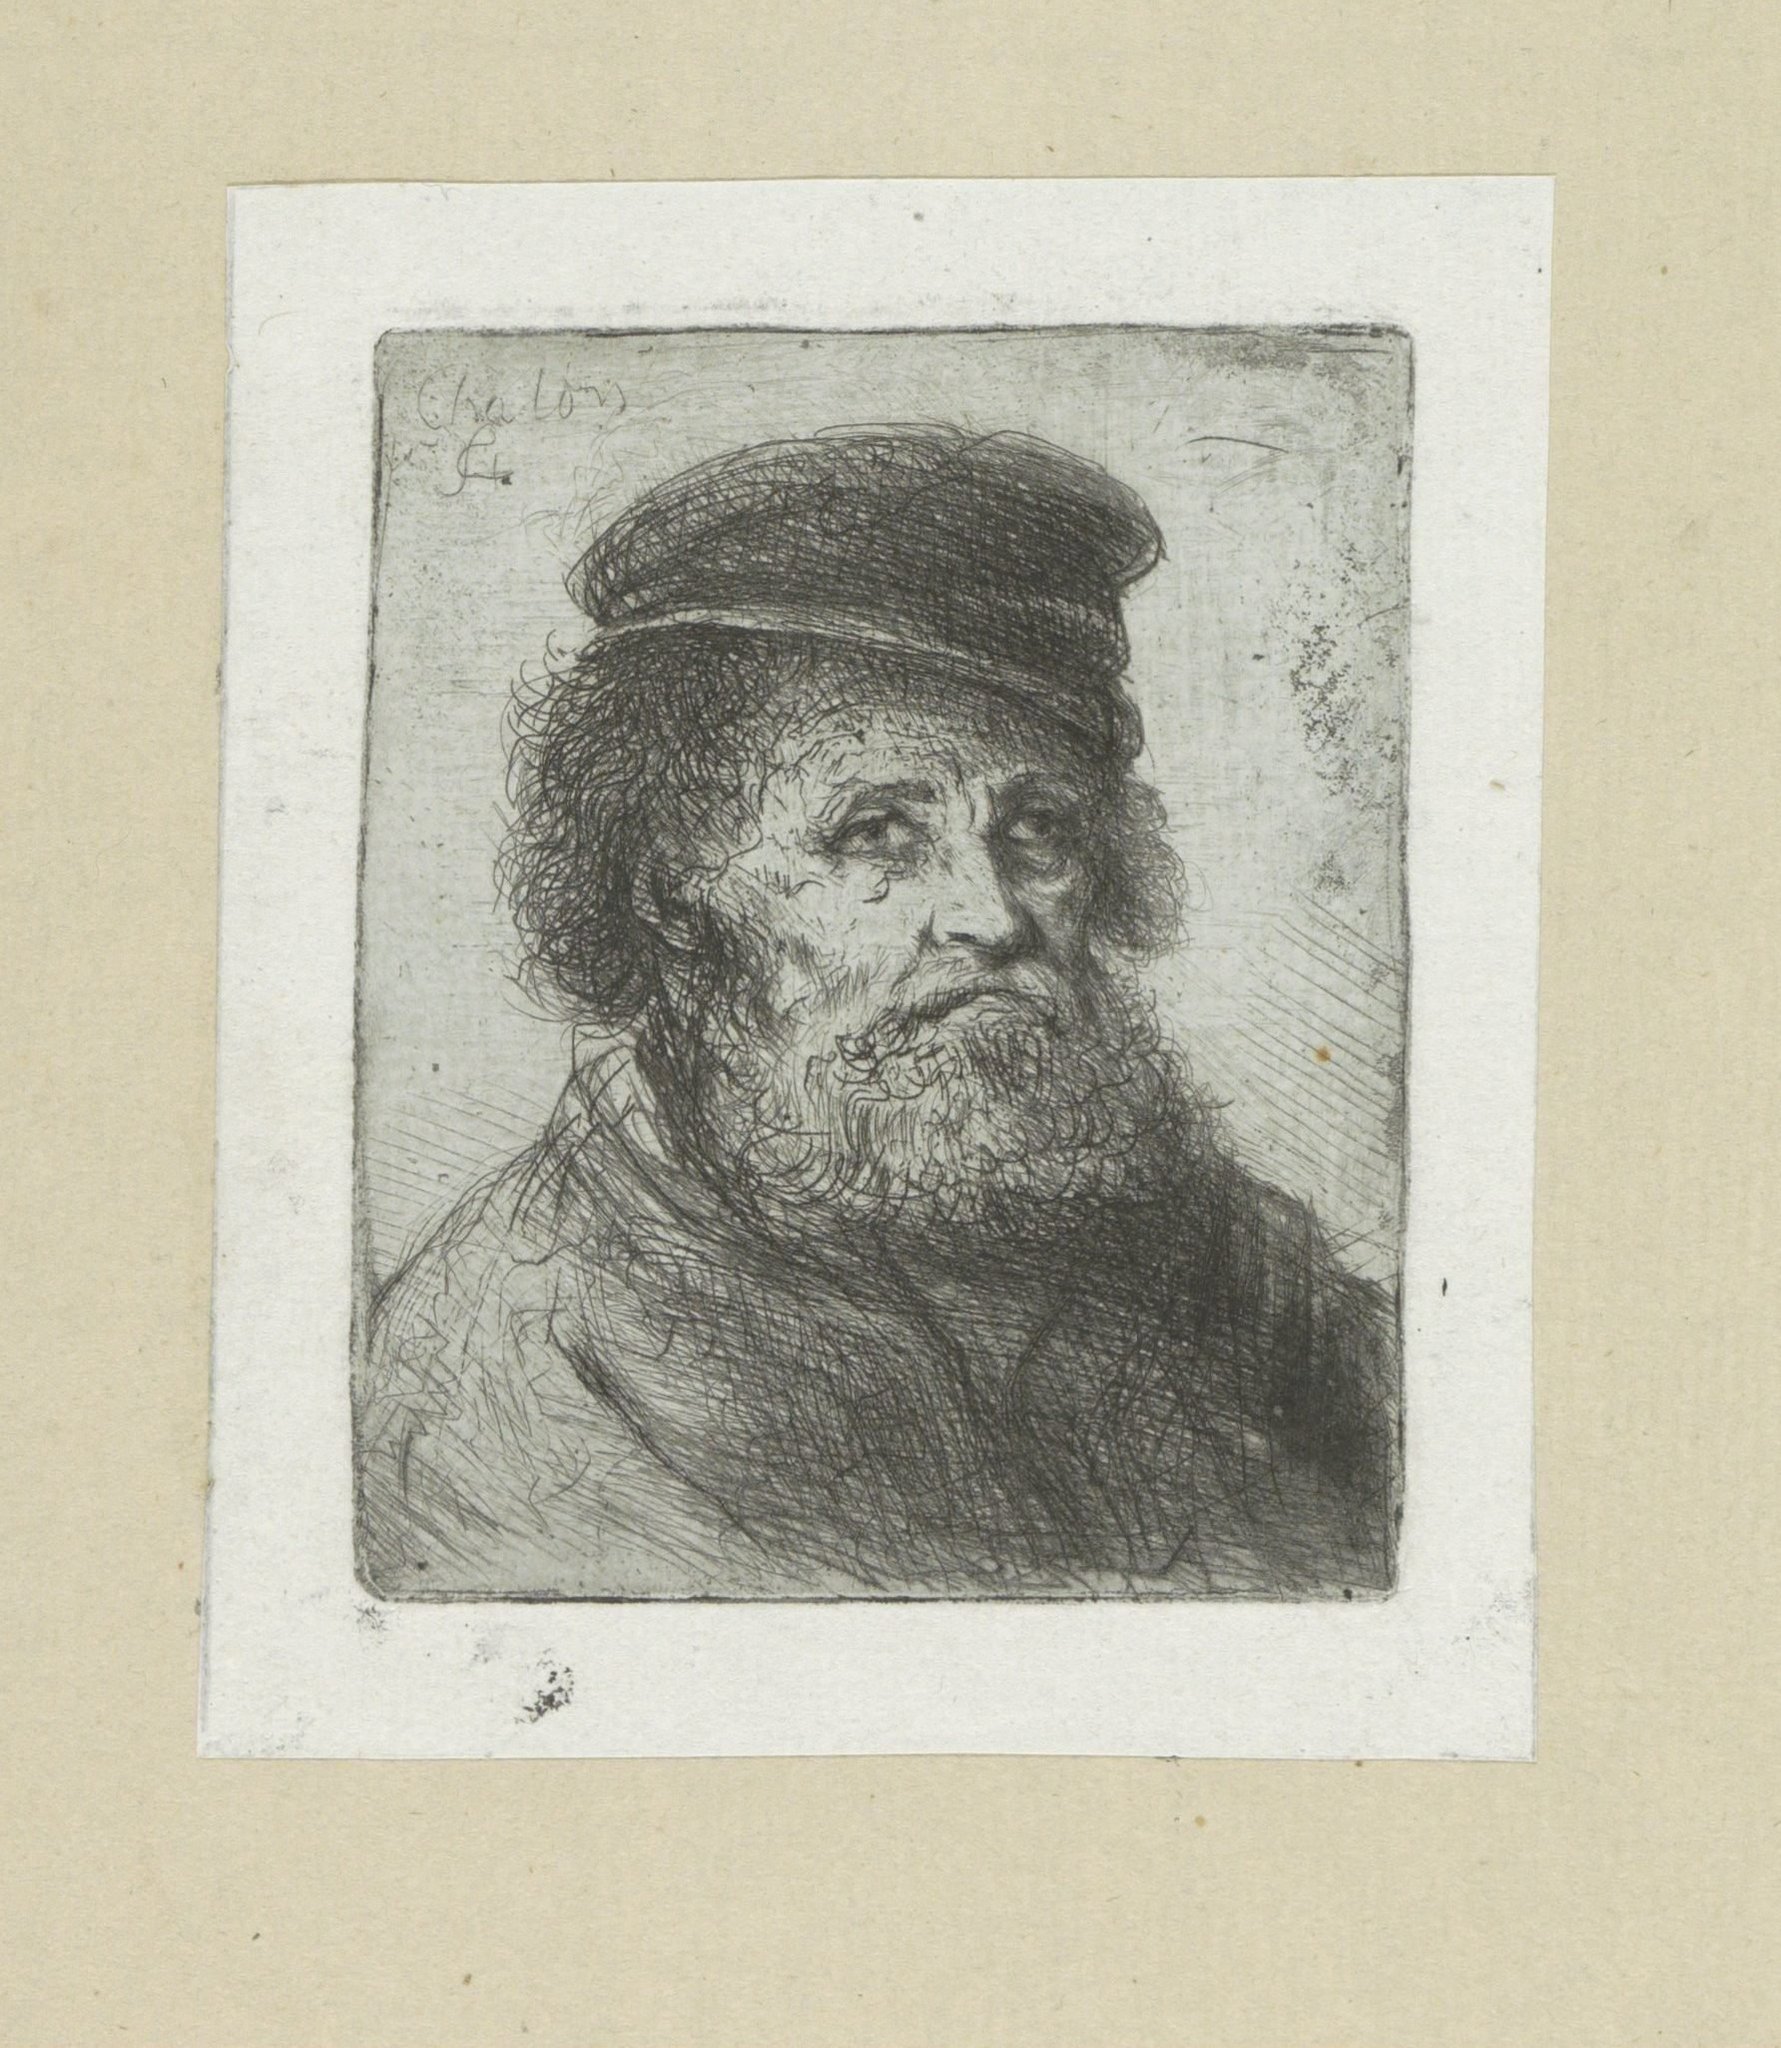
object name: album leaf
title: Oude man met baard en pet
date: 1802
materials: paper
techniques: drypoint, etching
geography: london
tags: head-gear: cap (+ men's clothes), old man, morphology of human expression (+ old male (human being))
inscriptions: collector's mark: ‘RIJKS / MUSM’, collector's mark: ‘B’